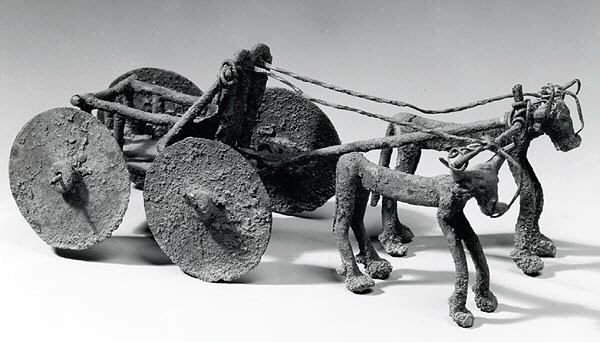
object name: wagon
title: Wagon drawn by bulls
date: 2700-2000 BCE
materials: copper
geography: anatolia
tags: bulls,wagons